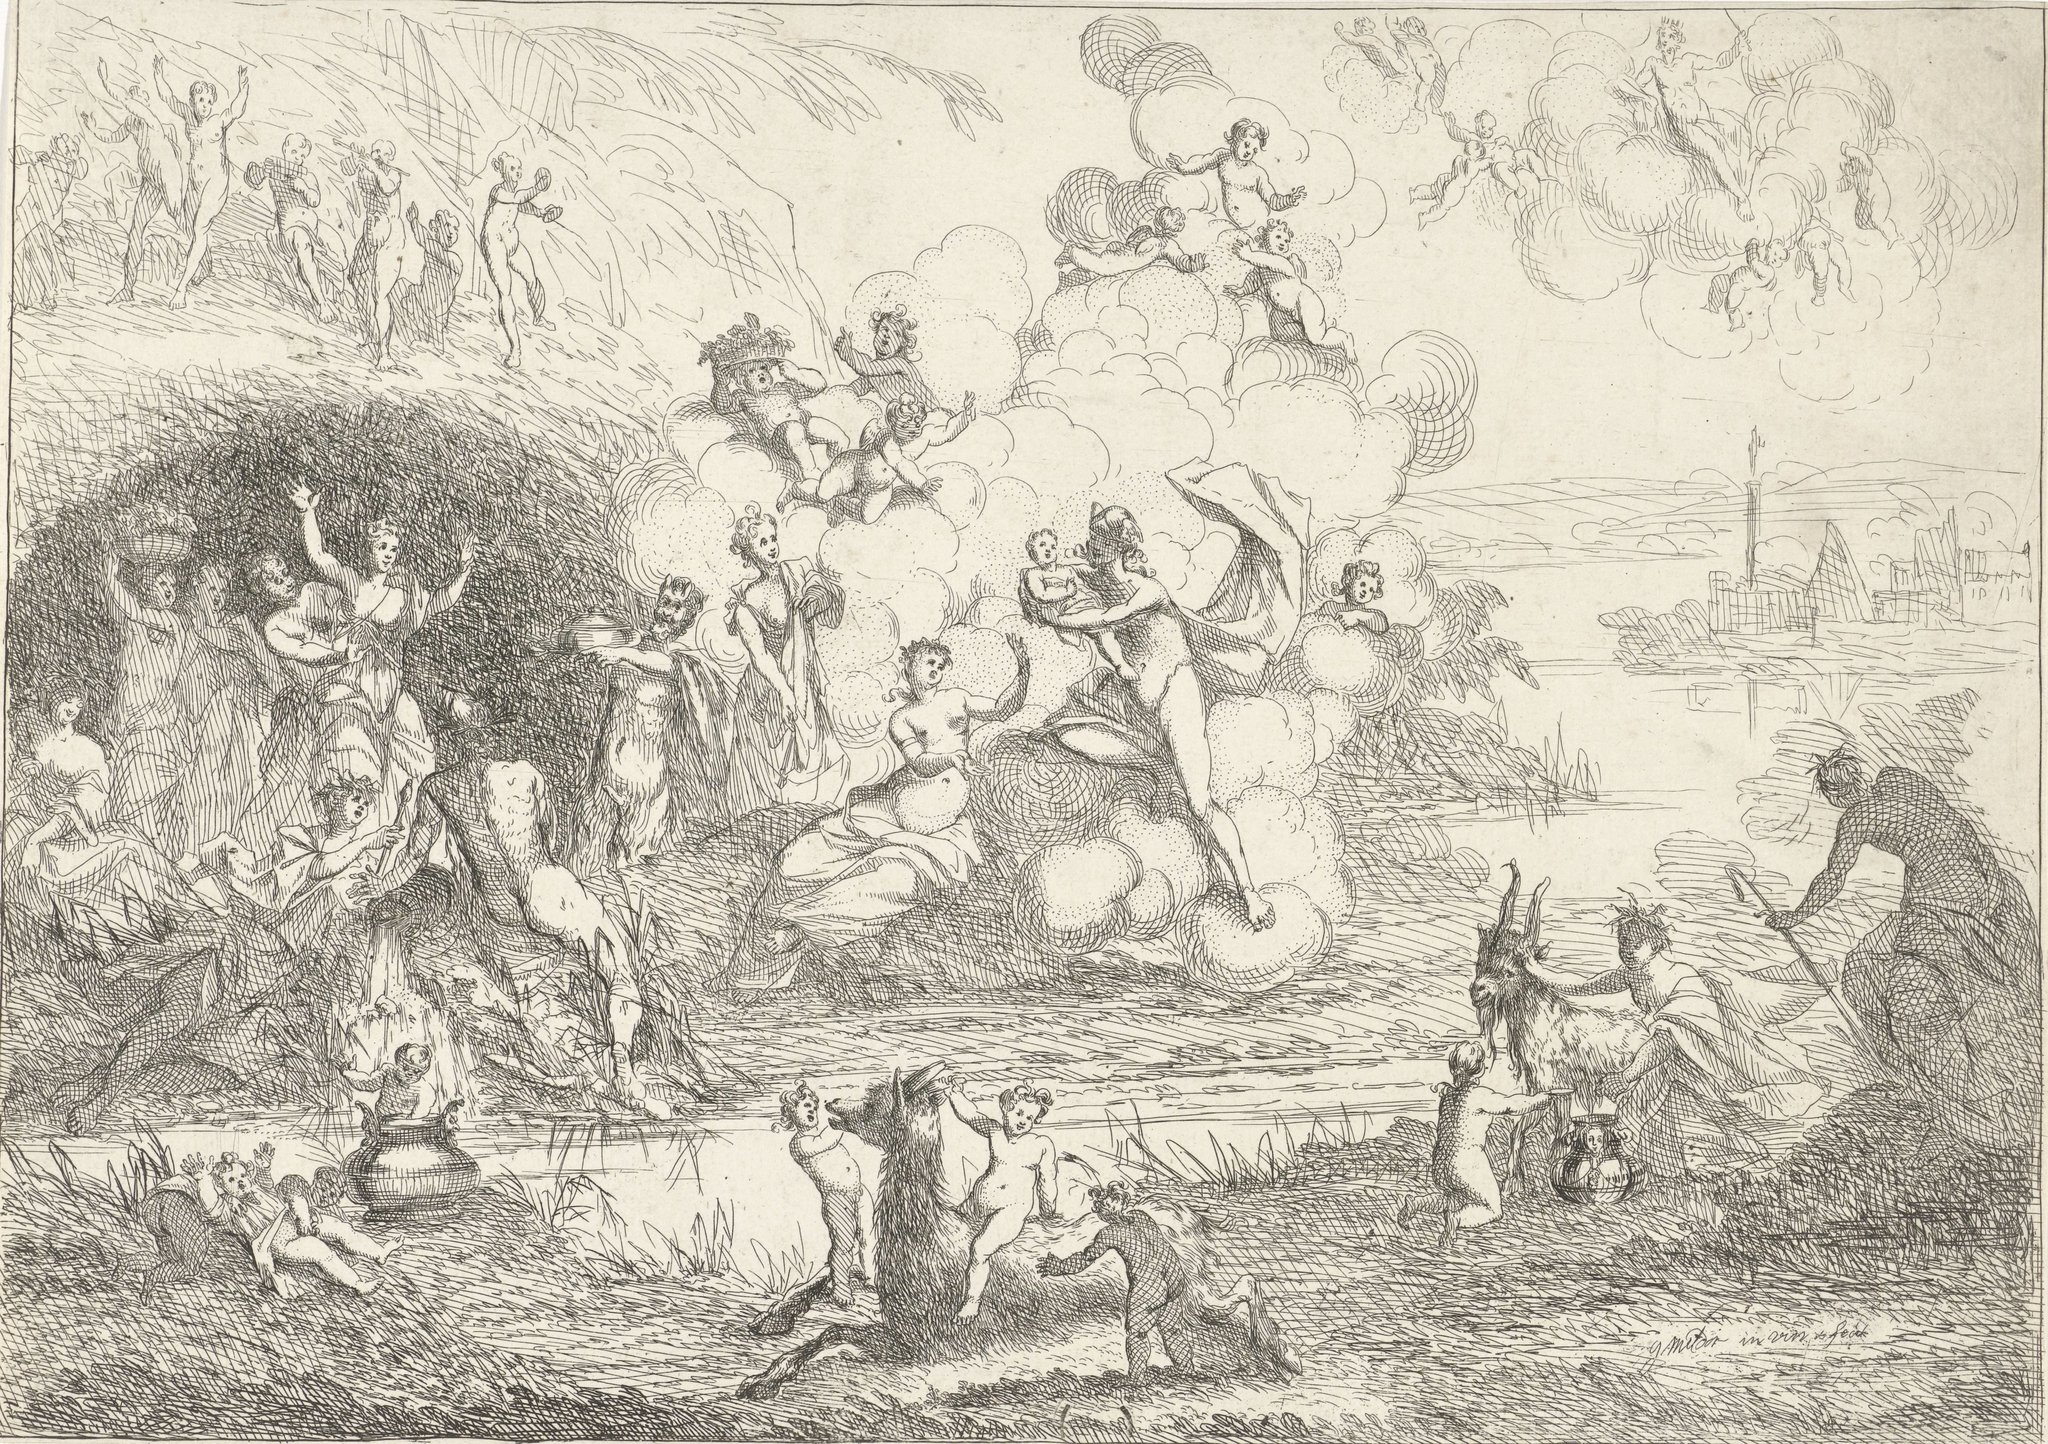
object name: print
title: Mercurius geeft Bacchus aan de nimfen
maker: gerard melder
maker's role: painter, print maker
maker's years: 1693-1754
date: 1725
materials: paper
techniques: etching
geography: amsterdam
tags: bacchanal: bacchus with his wine-flushed train (thiasos), mercury hands the baby bacchus over to the nymphs of nysa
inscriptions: collector's mark: Lugt 2228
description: Mercurius geeft het kind Bacchus ter opvoeding aan de nimfen van Nysa. Op de voorgrond in het midden spelen drie kinderen met een bok.